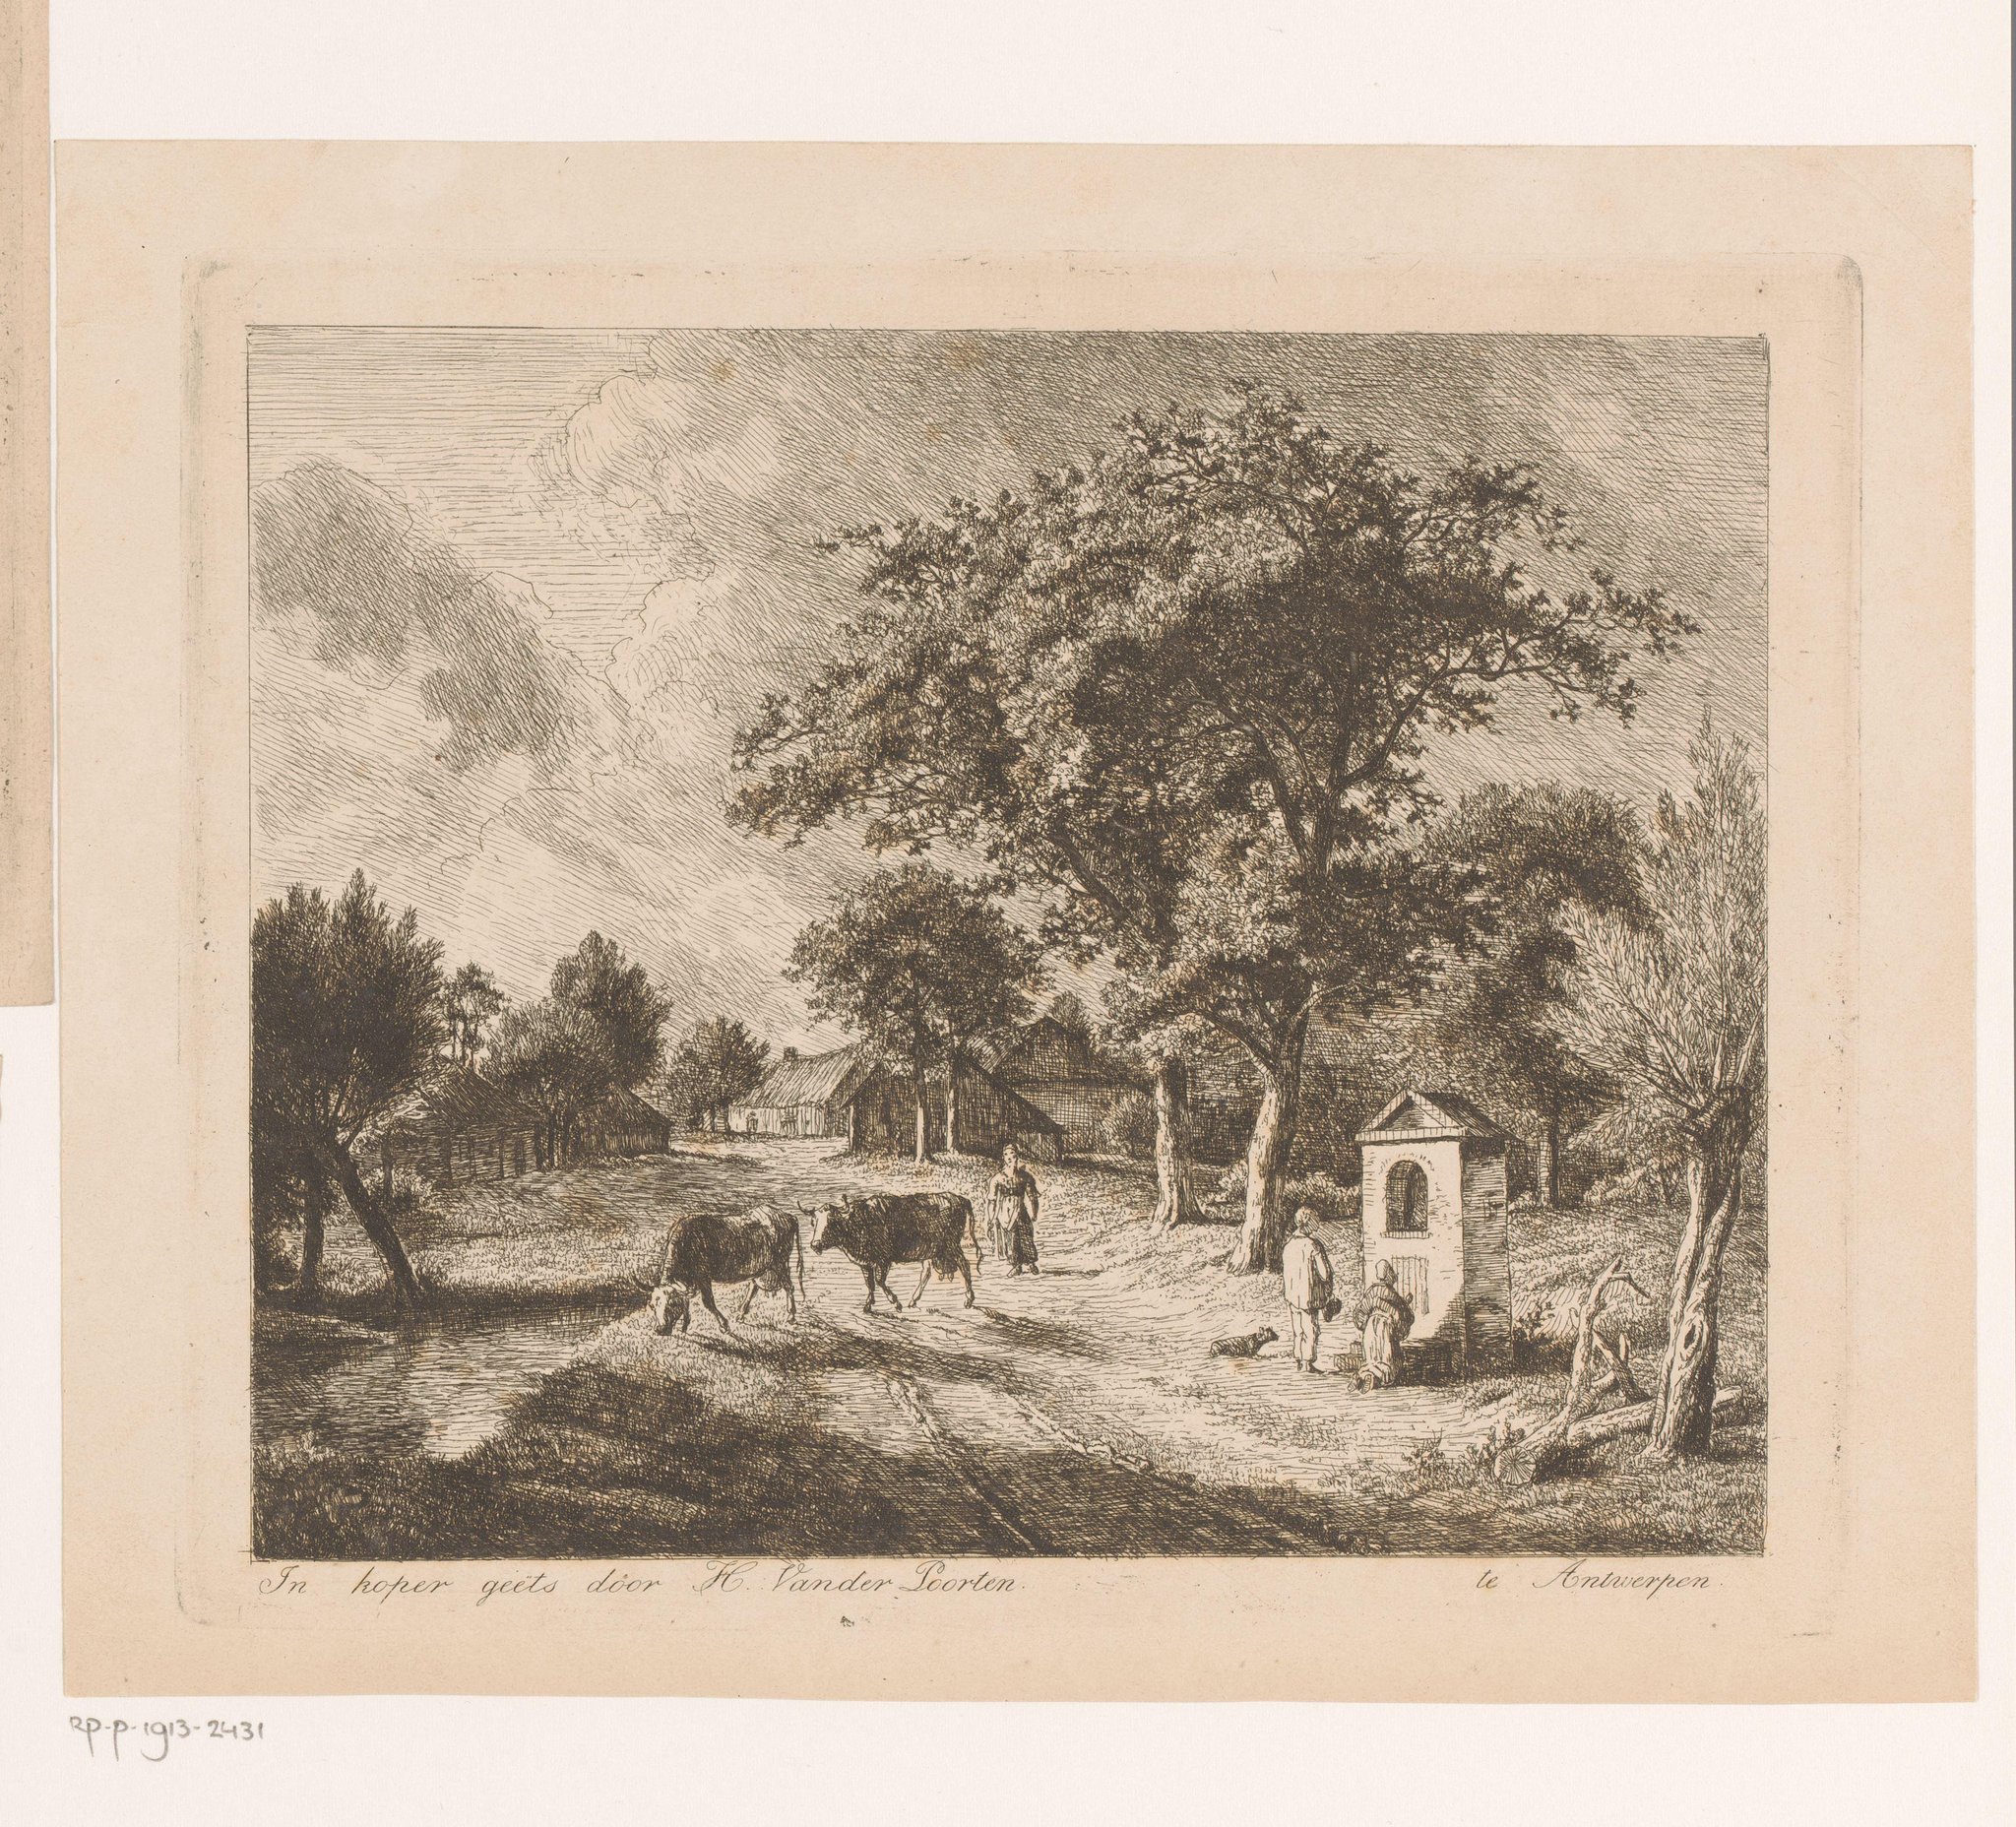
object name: print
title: Gebed voor een Mariakapel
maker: hendrik jozef franciscus van der poorten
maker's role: draughtsman, print maker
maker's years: 1789-1874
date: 1799-1841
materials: paper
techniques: drypoint, etching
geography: antwerp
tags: public road in village, mary devotion, one person praying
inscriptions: collector's mark: Lugt 1485, collector's mark: Lugt 2228